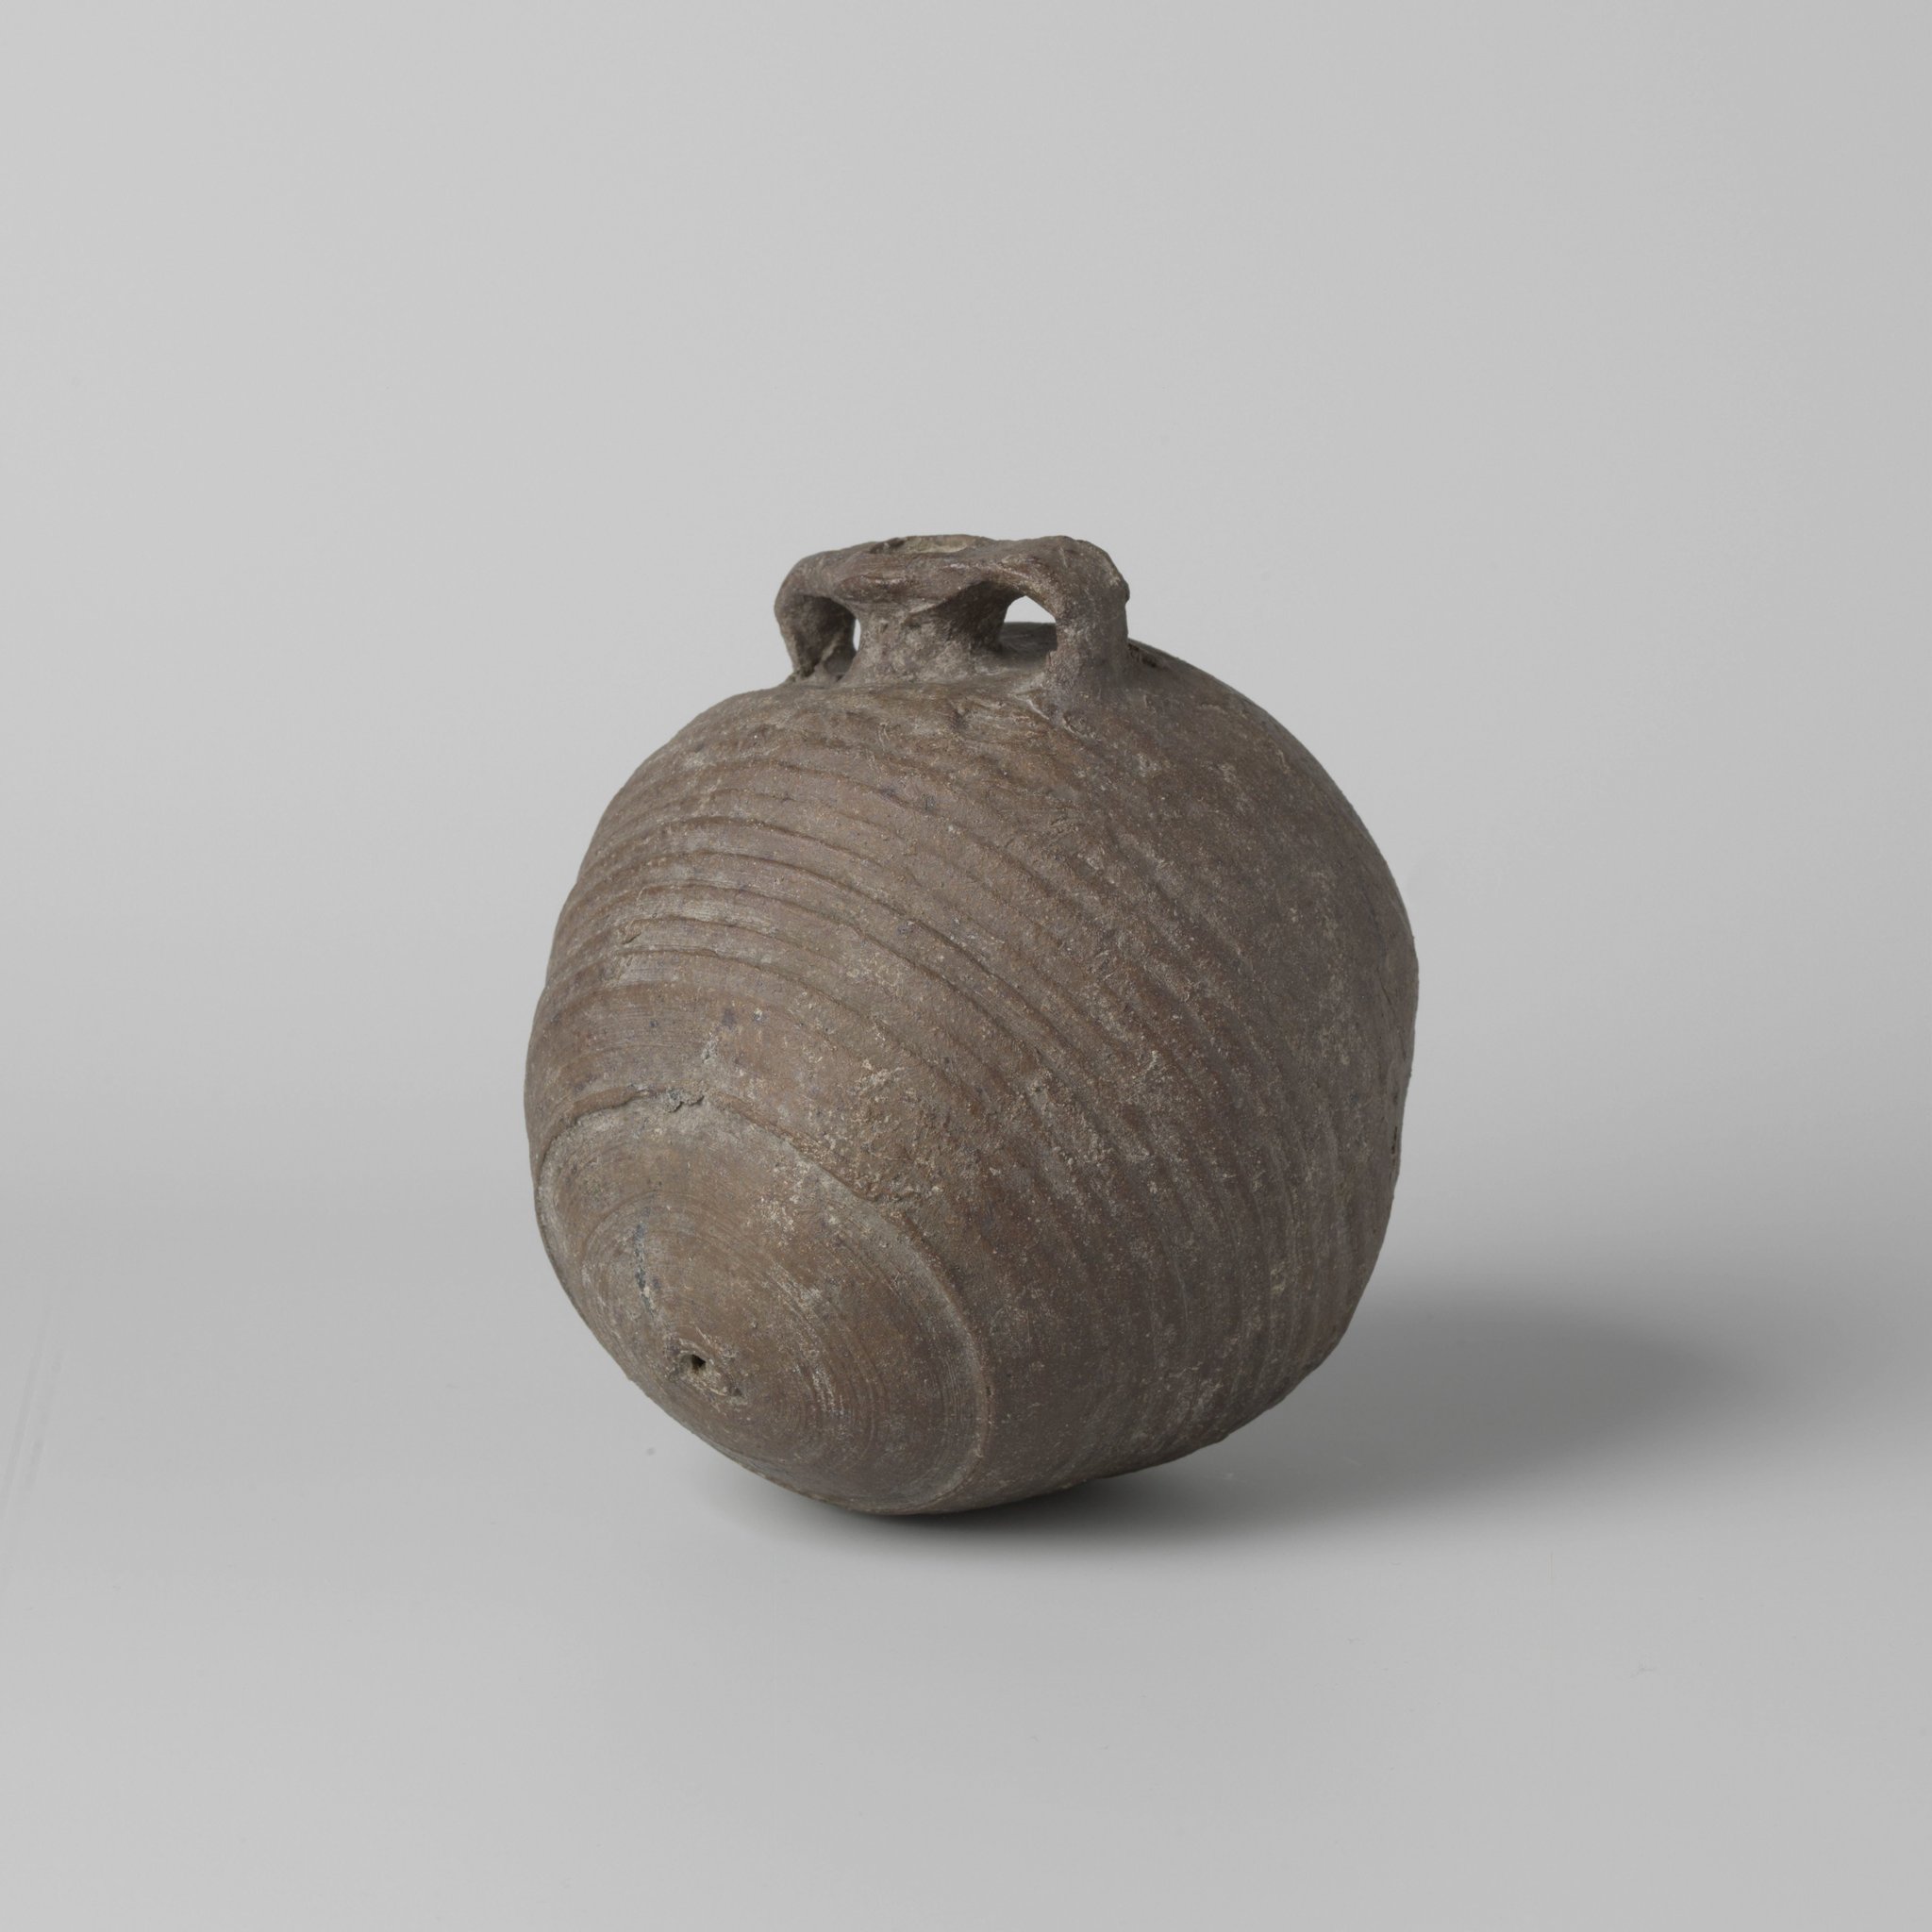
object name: jug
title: Kruik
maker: Anonymous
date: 1350-1450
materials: stoneware, tin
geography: netherlands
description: Ongeglazuurde kegelvormige kruik van steengoed, met twee oren. De buik is versierd met concentrische ringen in relief.